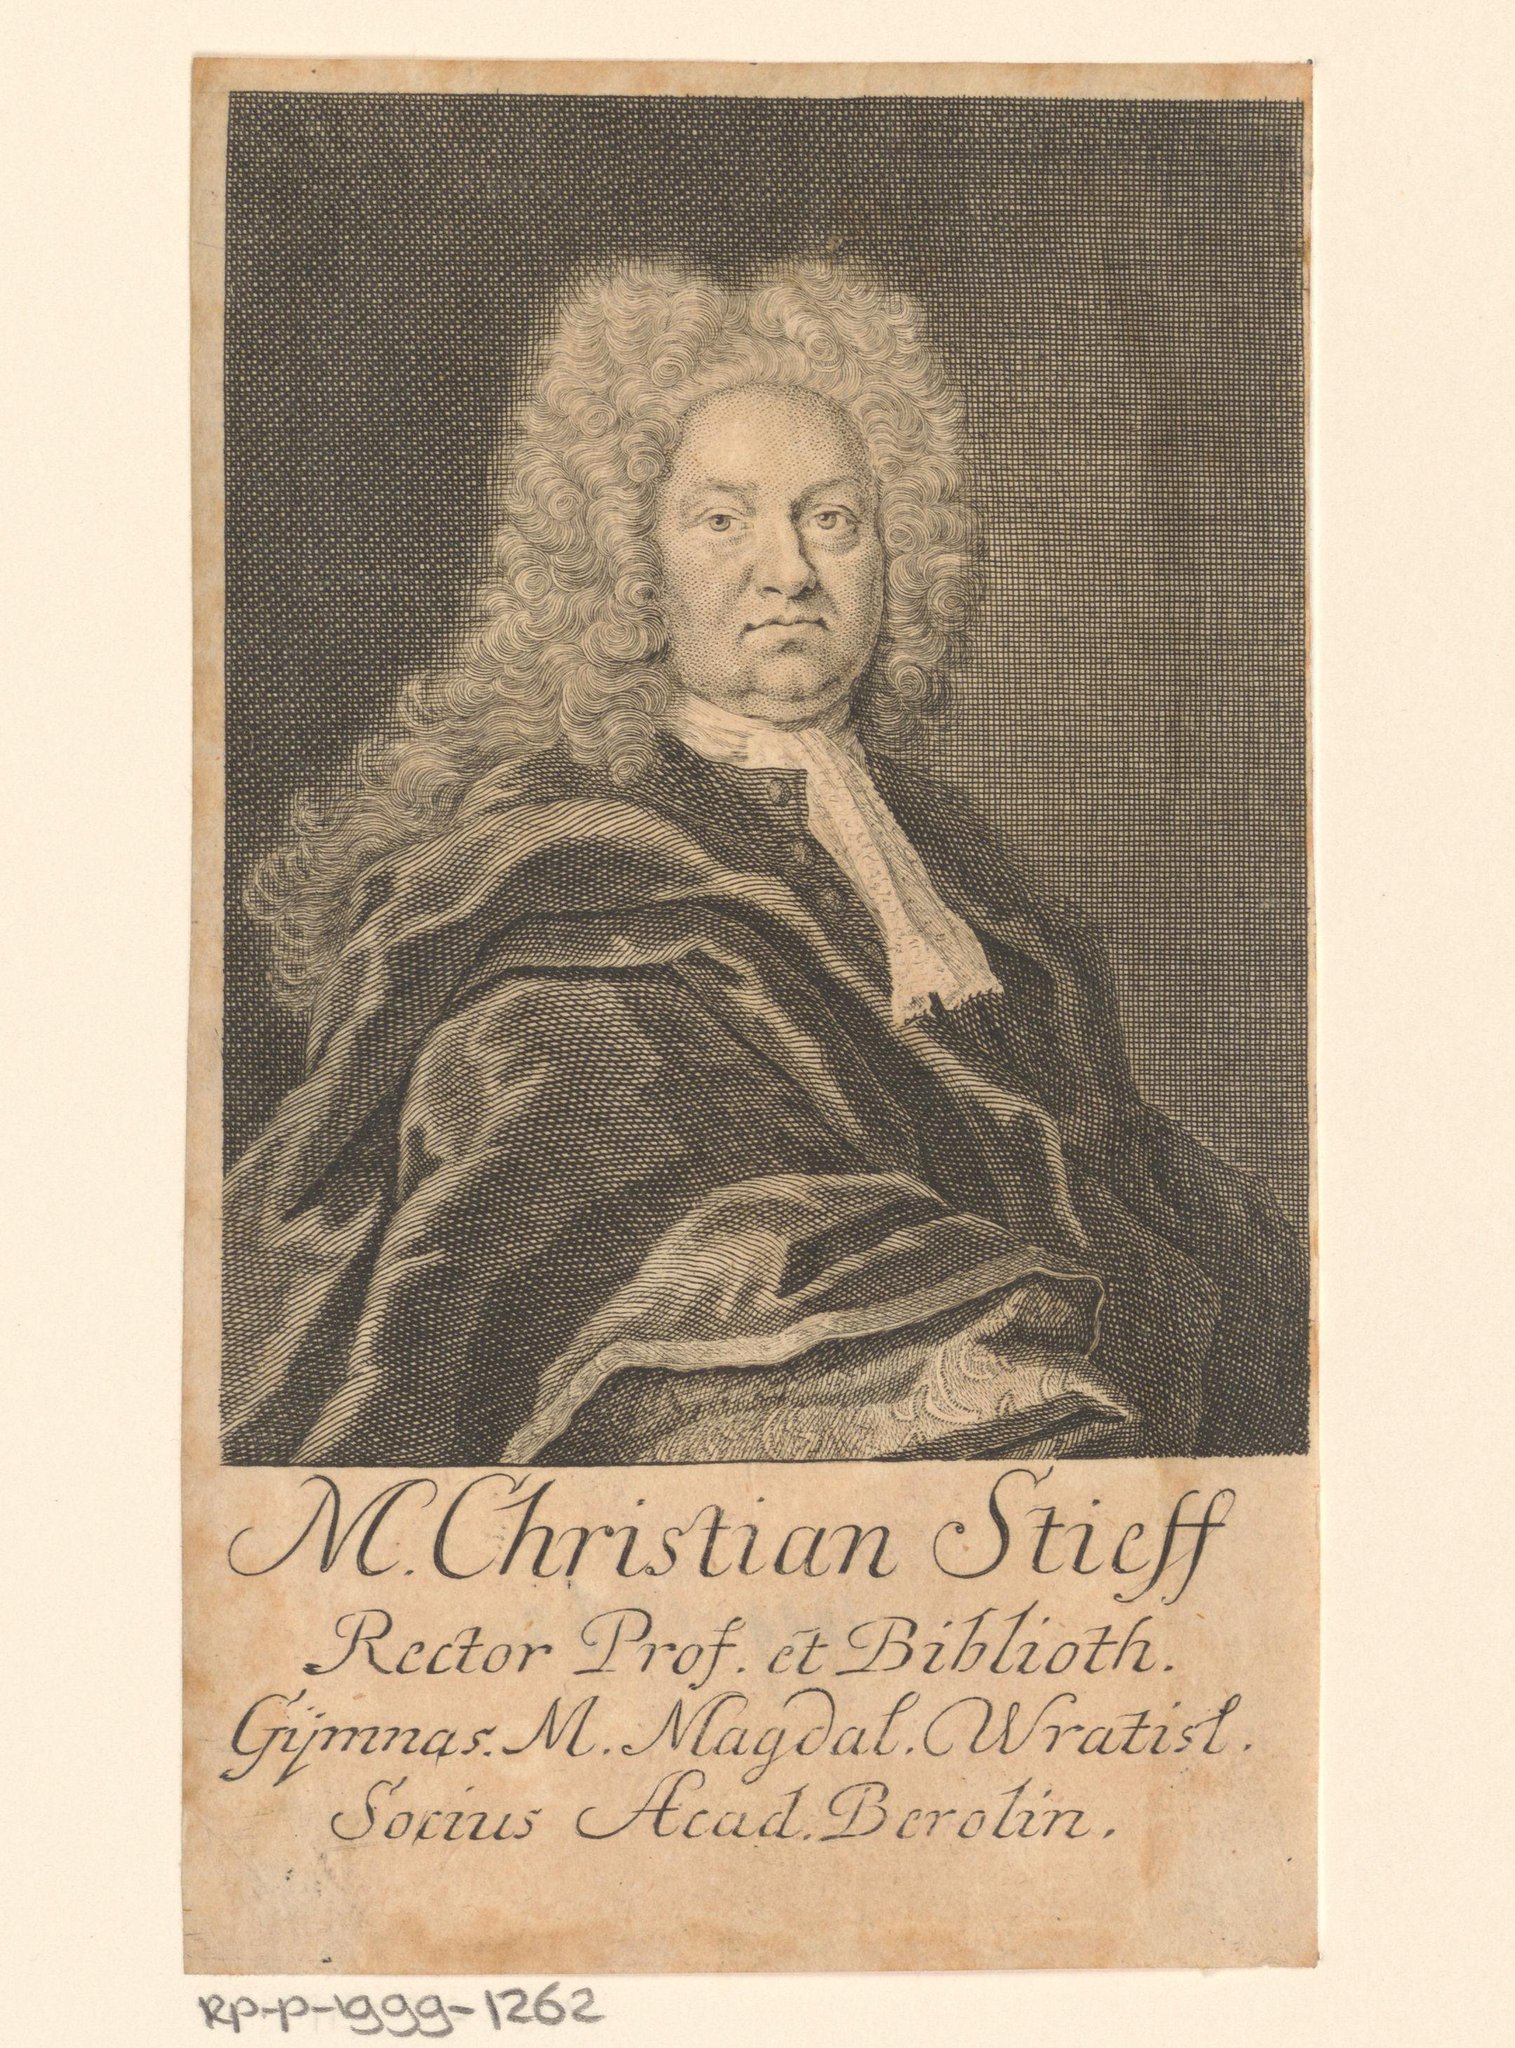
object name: print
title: Portret van Christian Stieff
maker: johann martin bernigeroth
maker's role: print maker, publisher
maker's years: 1713-1767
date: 1731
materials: paper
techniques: engraving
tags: christian stieff, historical persons, portrait of a writer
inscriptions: collector's mark: Lugt 2760, collector's mark: Lugt 2228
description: Prent waarschijnlijk uit: Deutsche Acta Eruditorum (...). Leipzig: Johann Gottlieb Gleditsch, 1731, dl. 162.